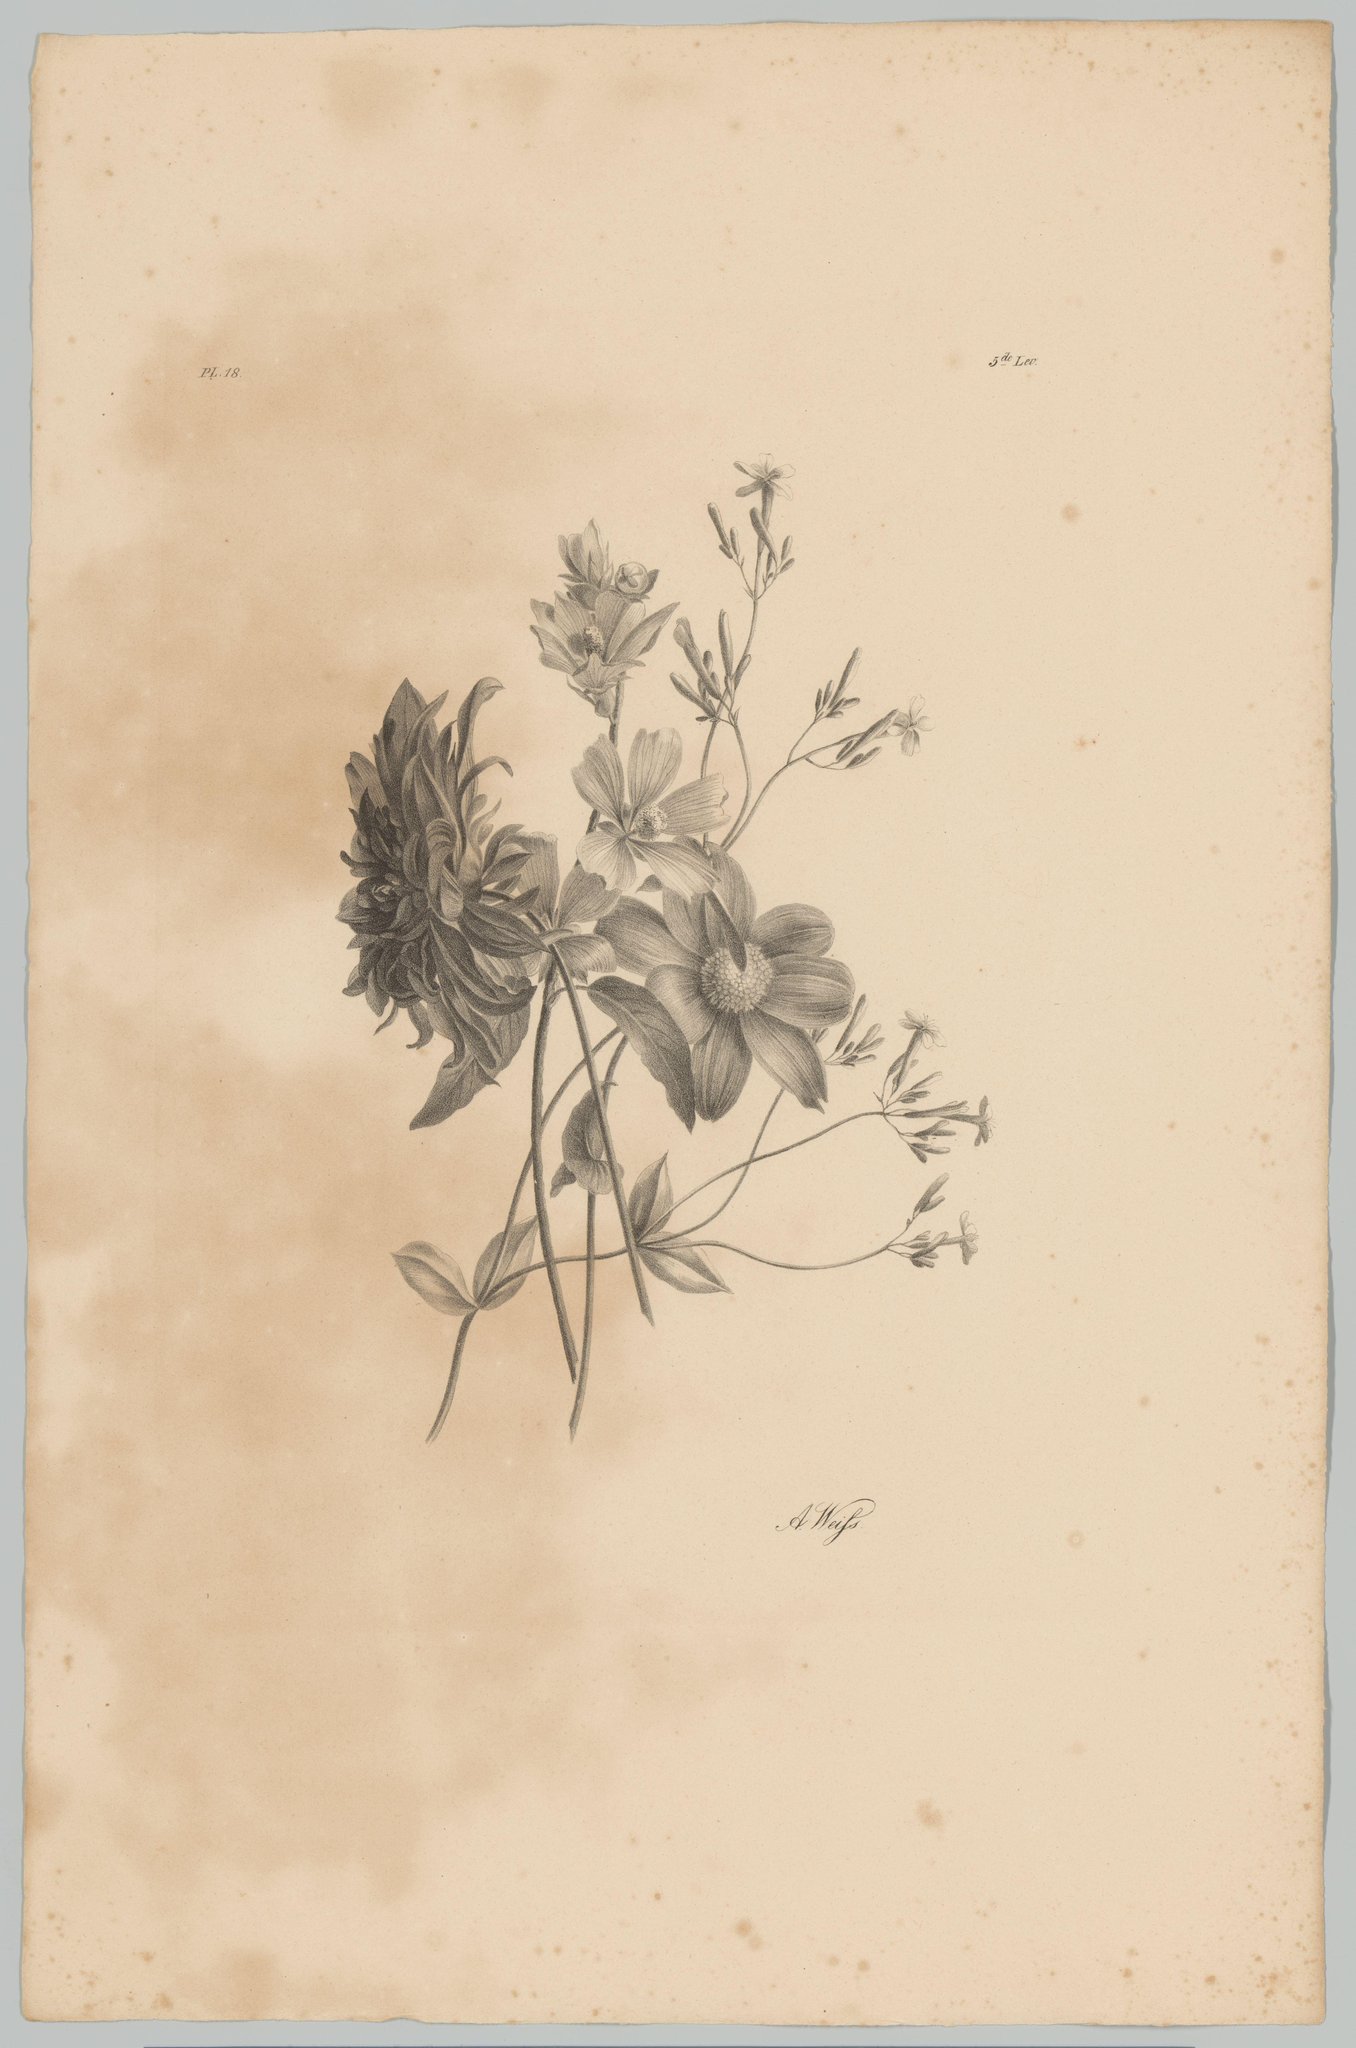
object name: print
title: Bloem en Fruit Studien (...) 3de aflevering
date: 1820-1833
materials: paper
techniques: lithograph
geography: amsterdam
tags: flowers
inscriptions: collector's mark: Lugt 2228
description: Rechts boven genummerd 5de Lev. Onderdeel van een omslag met in totaal zevenenzeventig lithografieën van bloemen en fruit.